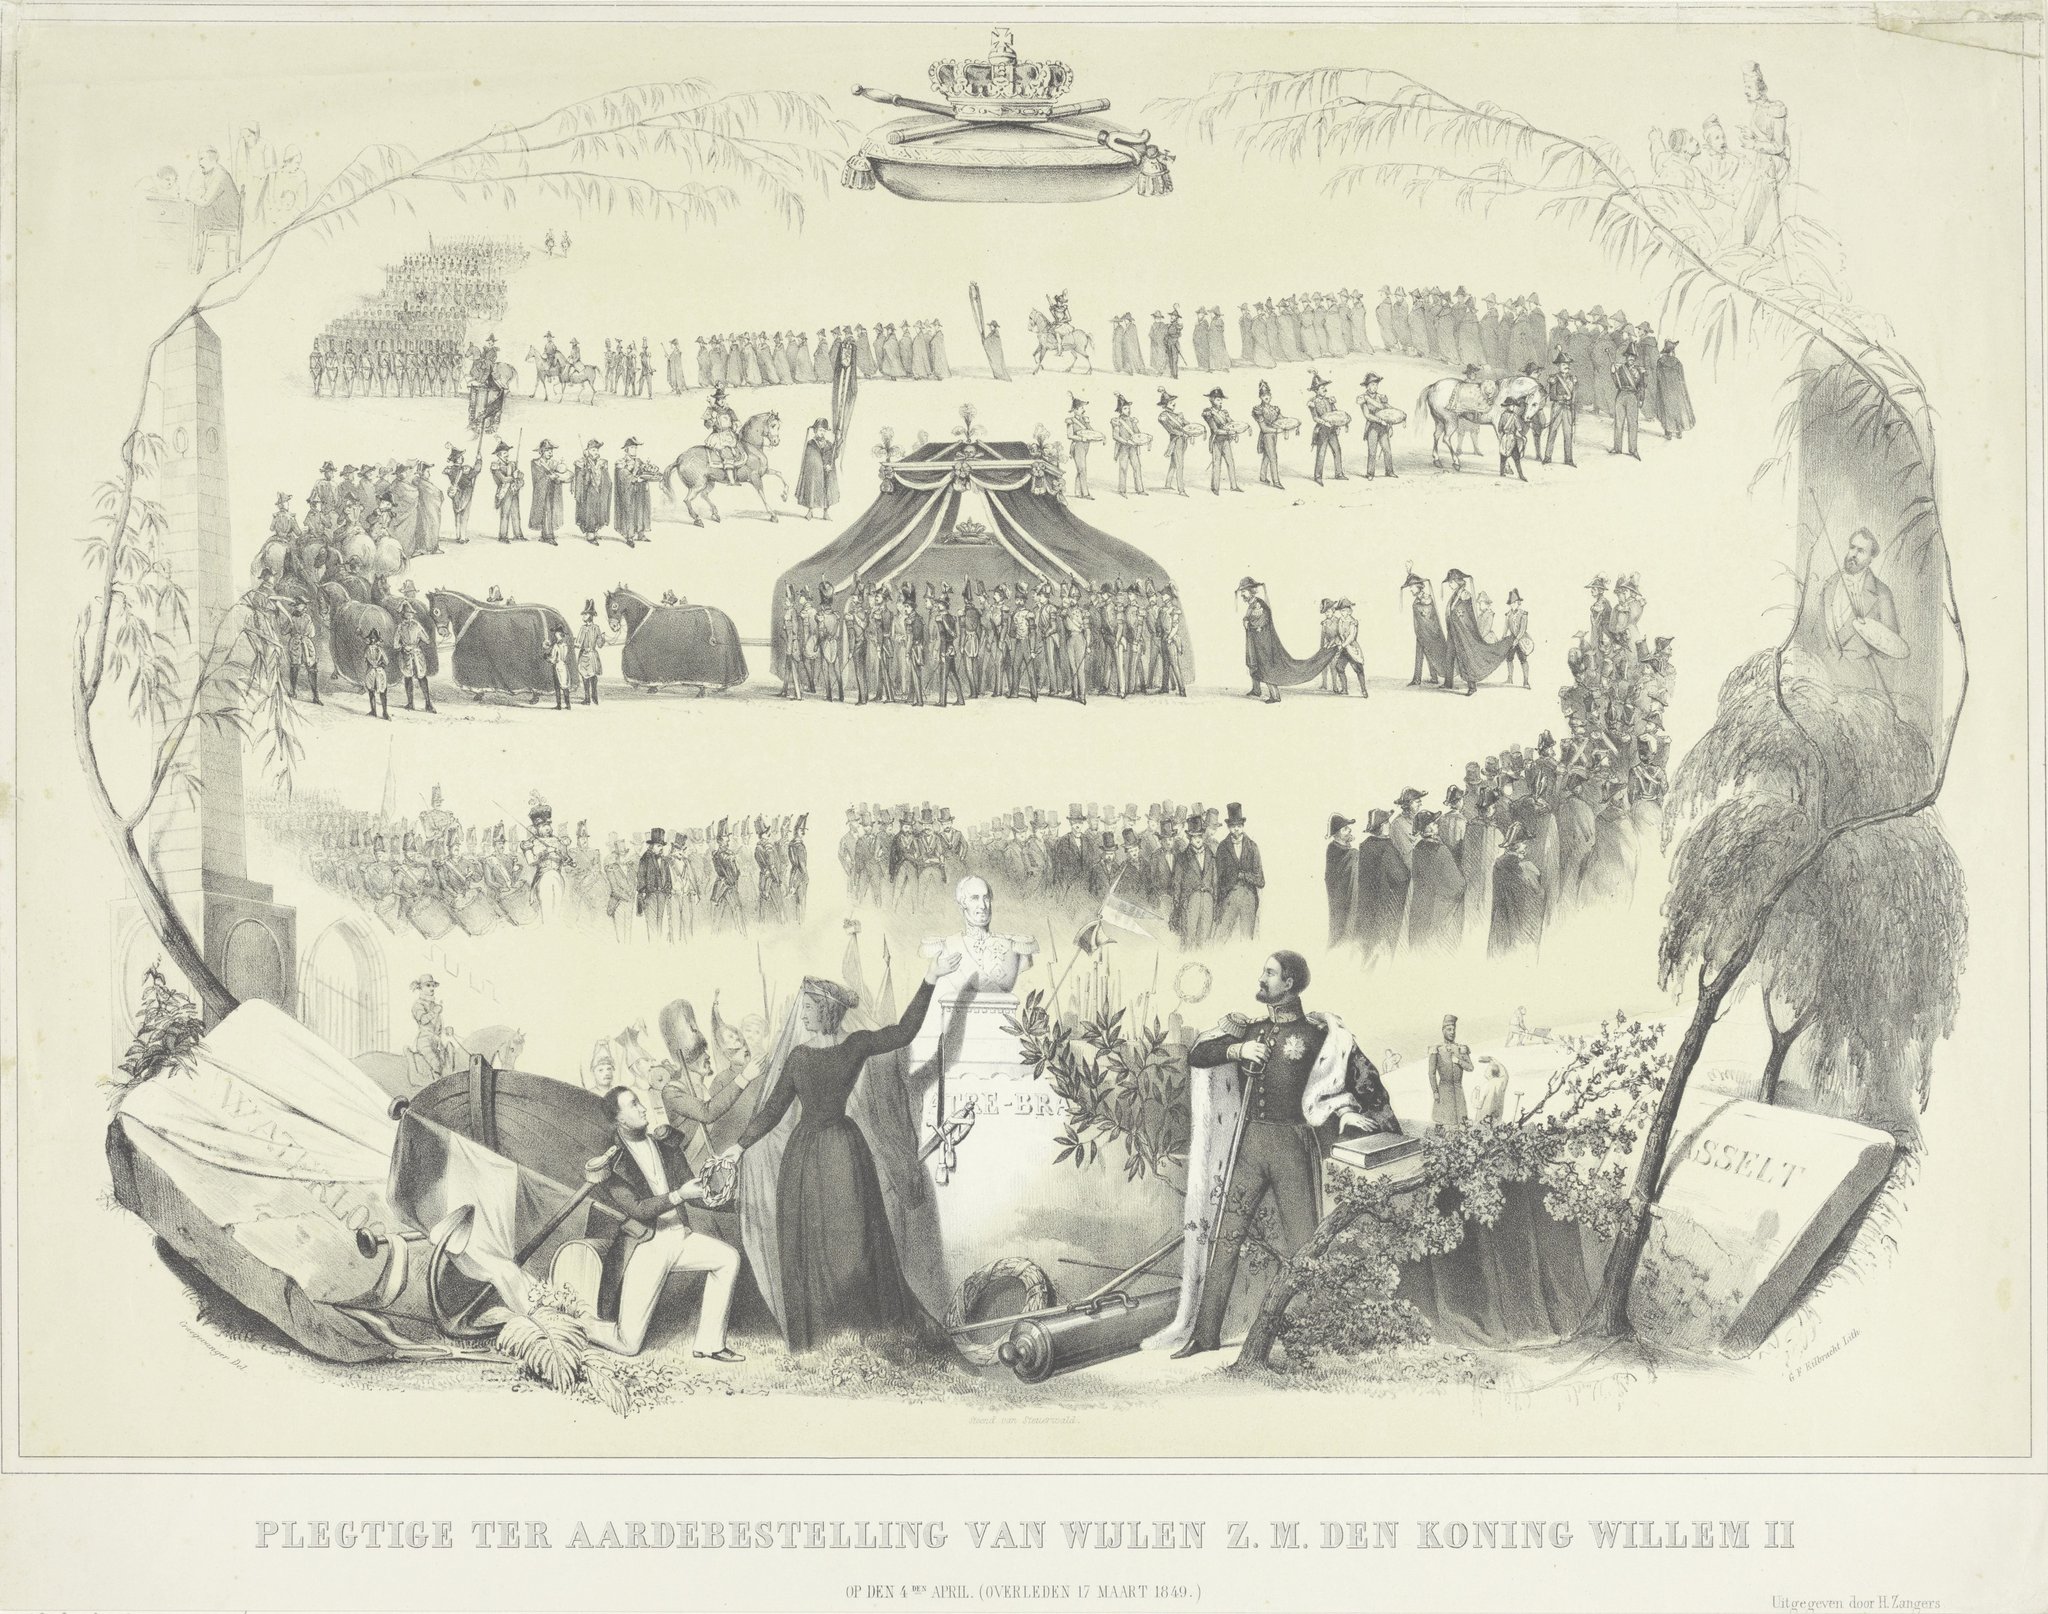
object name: print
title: Plegtige ter aardebestelling van wijlen Z.M. den Koning Willem II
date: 1849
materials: paper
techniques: tone lithography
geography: the hague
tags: brussels, willem iii (koning der nederlanden), the hague, william ii of the netherlands, cortege, funeral procession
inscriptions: collector's mark: Lugt 2228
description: In het midden van de stoet rijdt de lijkkoets, omringt door figuren en voortgetrokken door acht paarden. In de voorgrond staat een portretbuste van de koning met daaronder 'Quatre-Bras', een verwijzing naar de Slag bij Quatre-Bras op 16 juni 1815, twee dagen voor de slag bij Waterloo. Links van de buste staat een gesluierde vrouw die een lauwerkrans in ontvangst neemt van een geknielde figuur. Rechts van de buste staat een derde figuur, waarschijnlijk Willem III, de opvolger van Koning Willem II. Hij houdt een zwaard aan zijn borst legt zijn linkerhand op een boek, waarschijnlijk een Bijbel. Links en rechts liggen grote stenen met daarop de plaatsnamen: 'Waterloo' en 'Hasselt'.